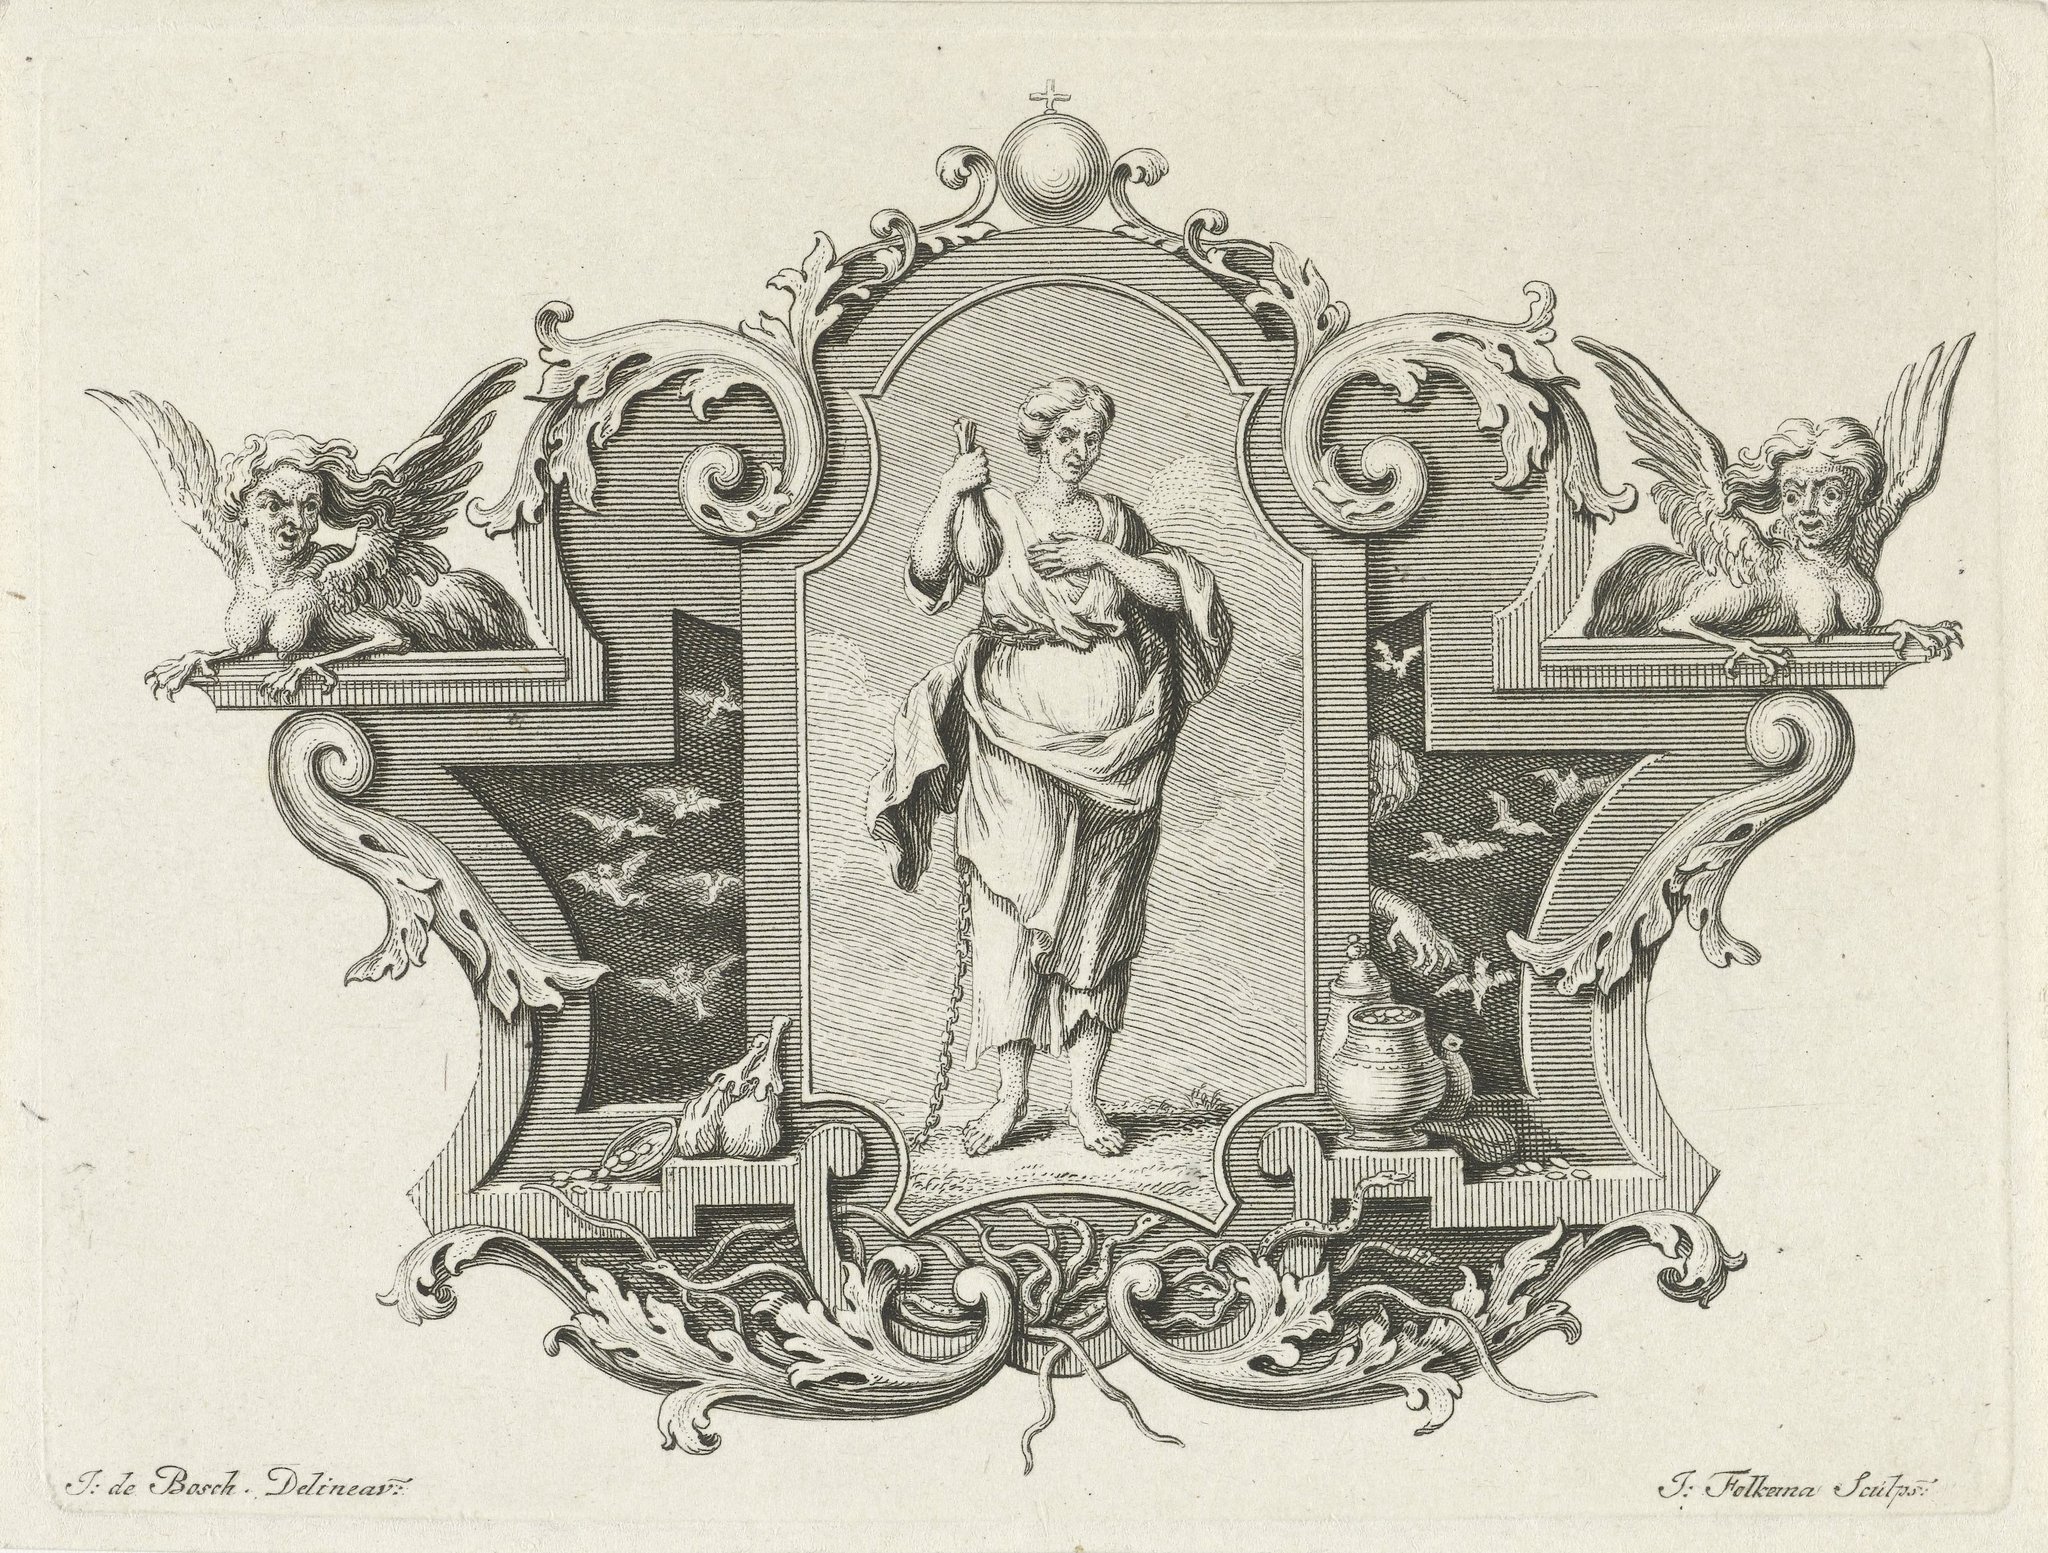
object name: book illustration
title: Vignet met de personificatie van Gierigheid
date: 1723-1767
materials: paper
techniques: etching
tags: covetousness; 'avaritia' (ripa) ~ personification of one of the seven deadly sins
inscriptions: collector's mark: Lugt 240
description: Vignet met de beeltenis van de gepersonifieerde Gierigheid in een cartouche, omringd door duivelse figuren, slangen en geld. Ze houdt een geldzak in haar hand en draagt een ketting om haar middel. De prent maakt deel uit van een reeks boekillustraties over deugden en ondeugden.